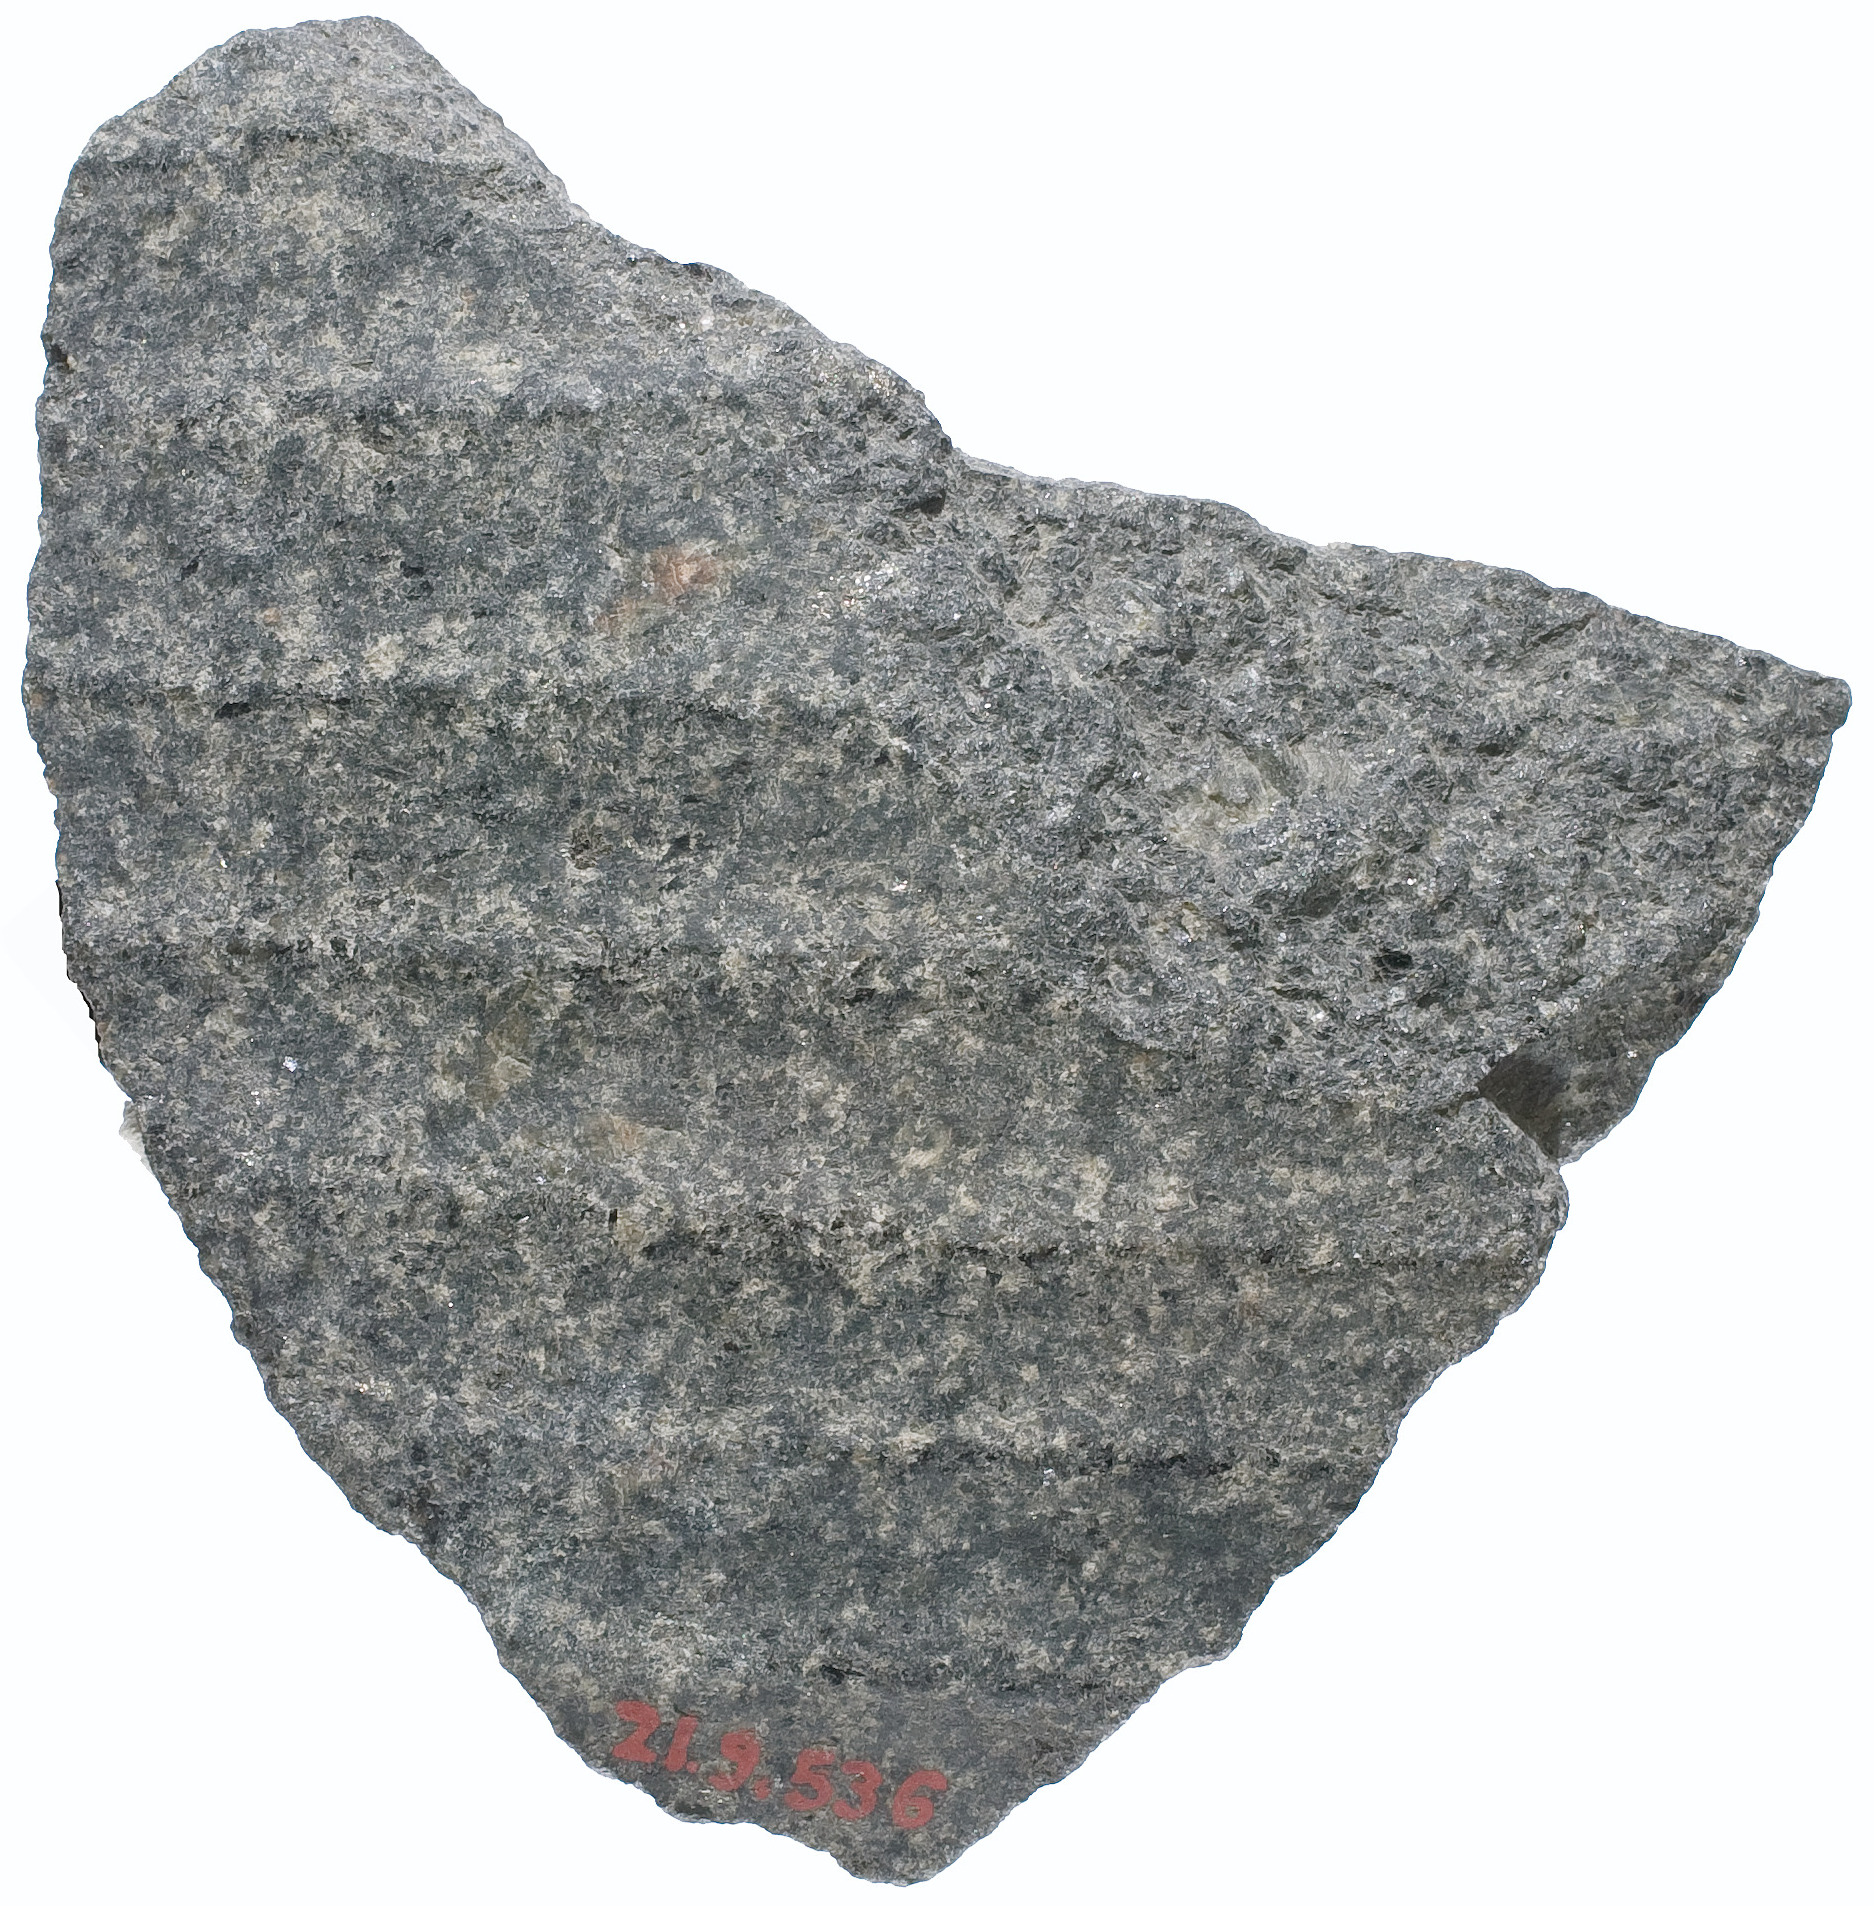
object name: garment pleat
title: Body fragment with garment pleats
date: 1353-1336 BCE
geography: egypt